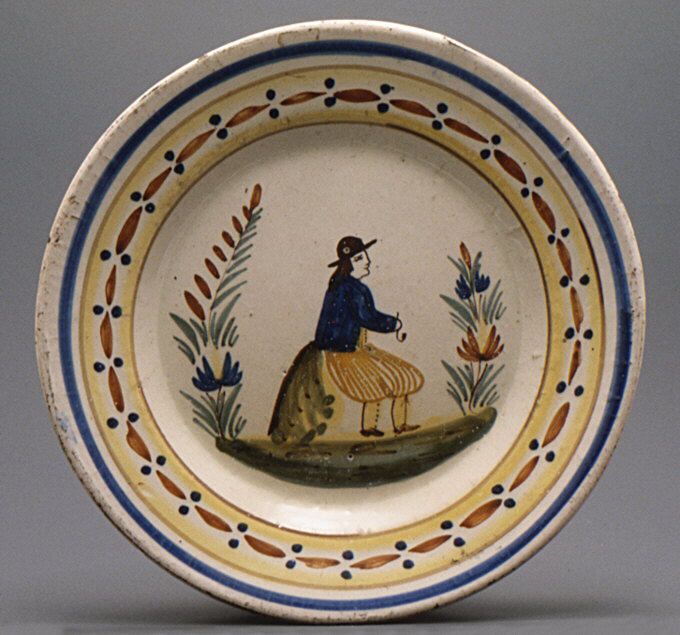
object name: plate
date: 1701-1900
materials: stoneware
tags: human figures,plants